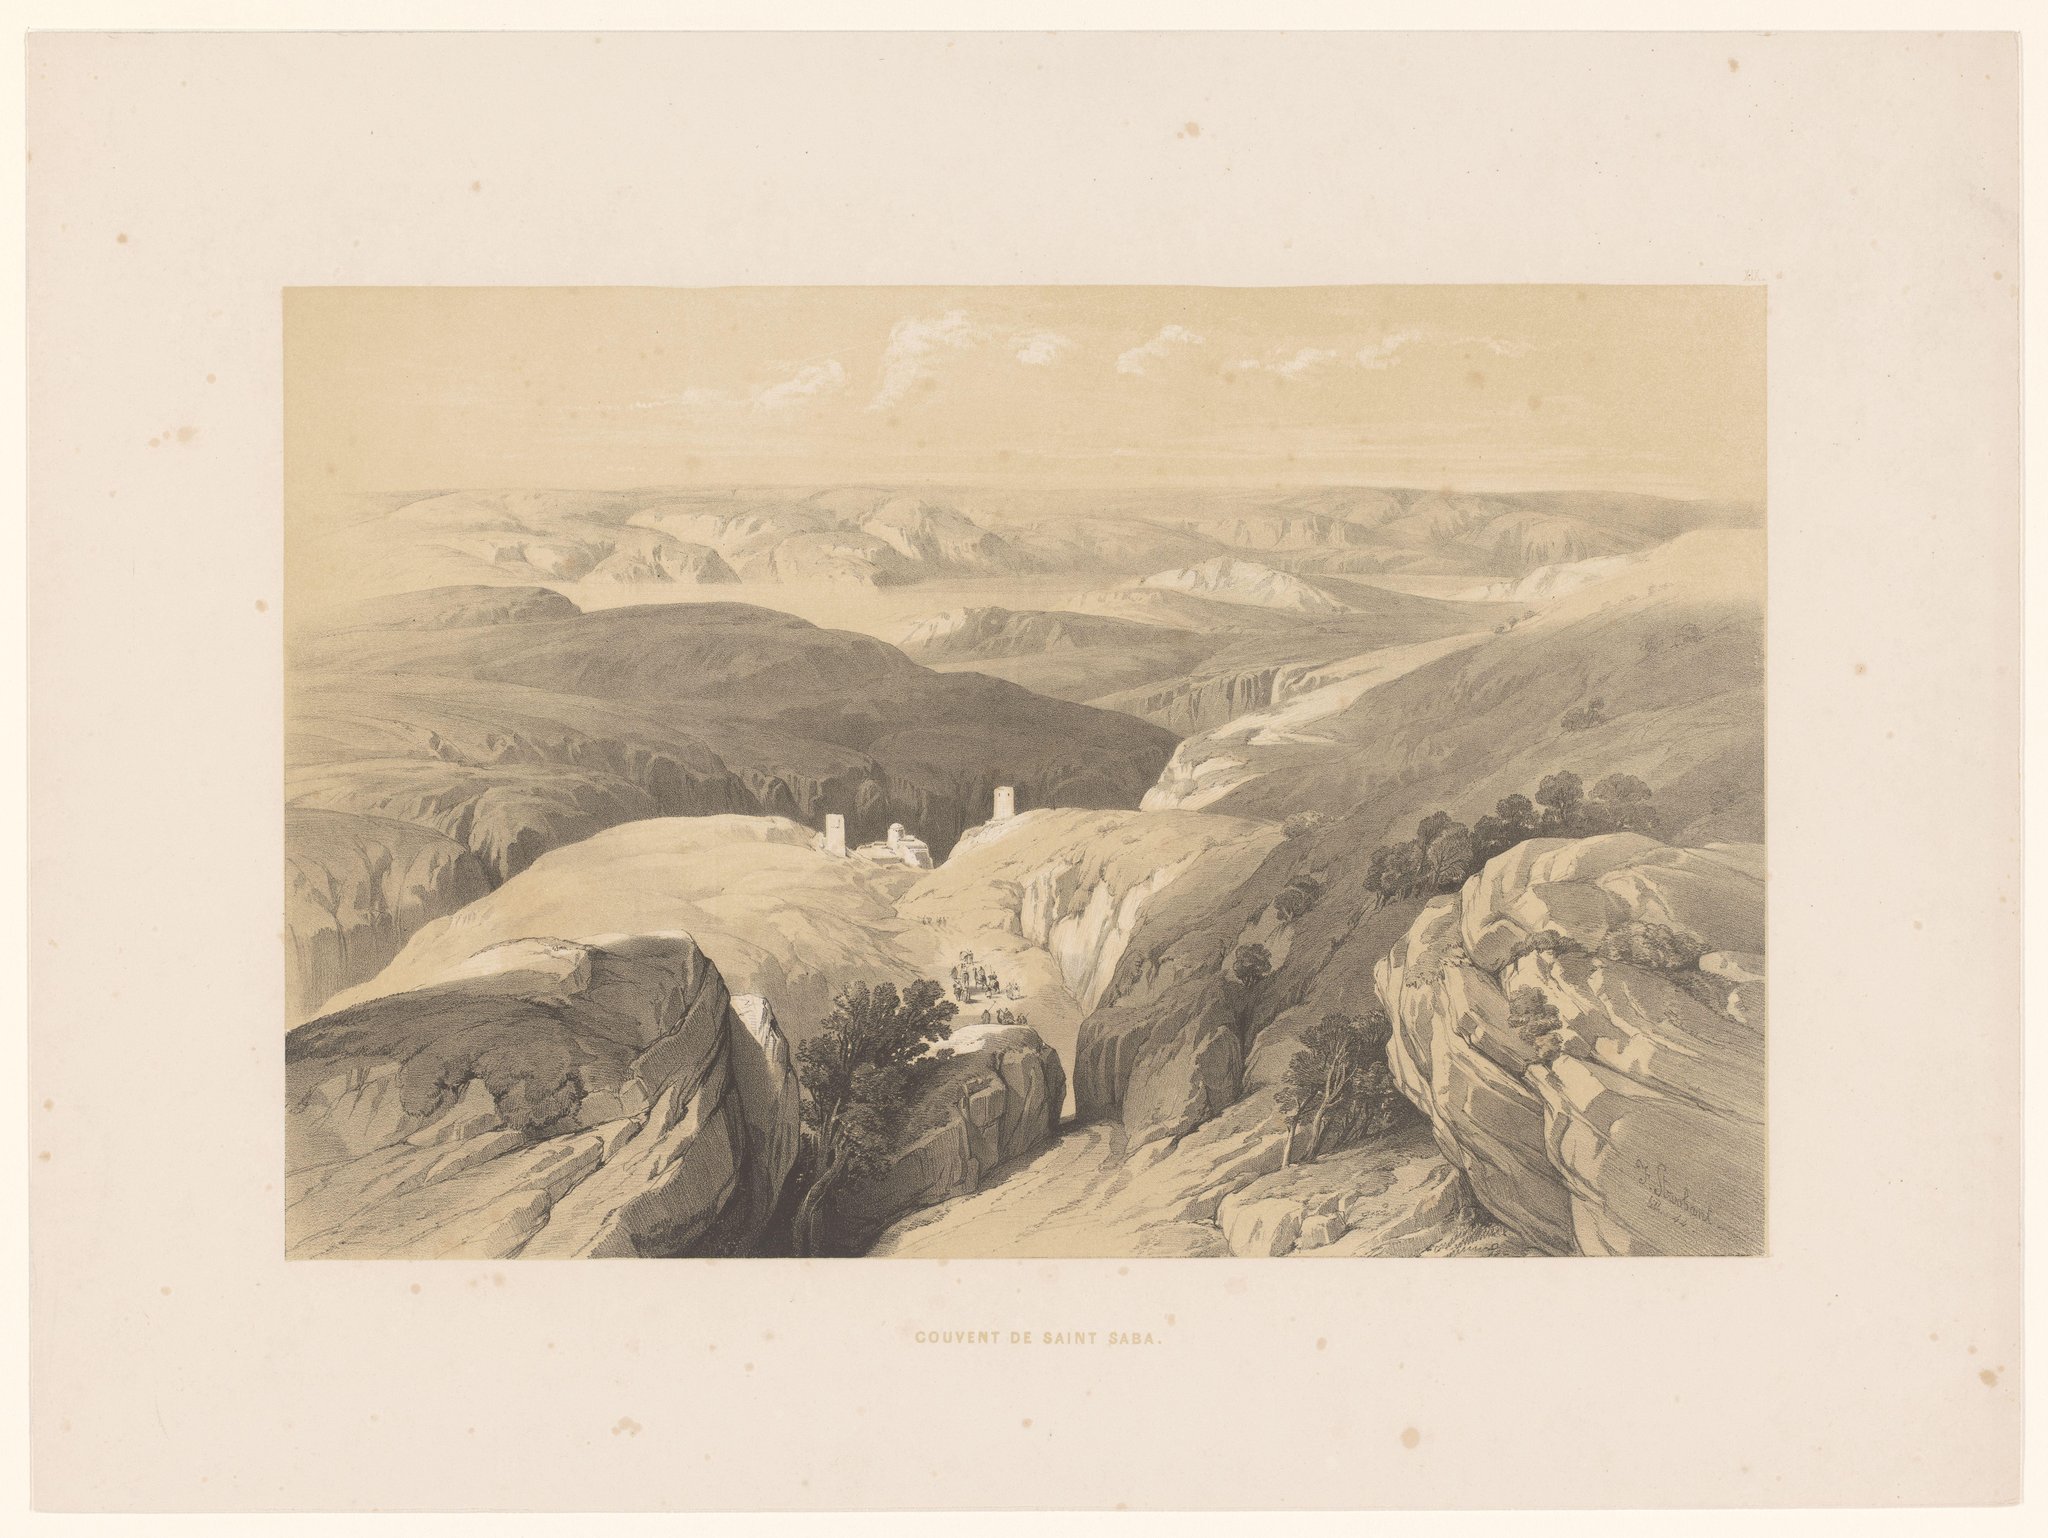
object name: print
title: Gezicht op Mar Saba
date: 1852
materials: paper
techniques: tone lithography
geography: brussels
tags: low hill country, abbey, monastery, convent ~ roman catholic church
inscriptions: collector's mark: Lugt 2228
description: Jules Géruzet maakt in 1852 een heruitgave van het Belgische werk 'La terre sainte. Vues et monuments recueillis par David Roberts de l'Académie de Londres' dat tussen 1843-1845 wordt gedrukt door J. Lots en waarvan de prenten, op verzoek van de Société des Beaux-Arts, door Ghemar en Stroobant worden uitgevoerd naar werken van Haghe.